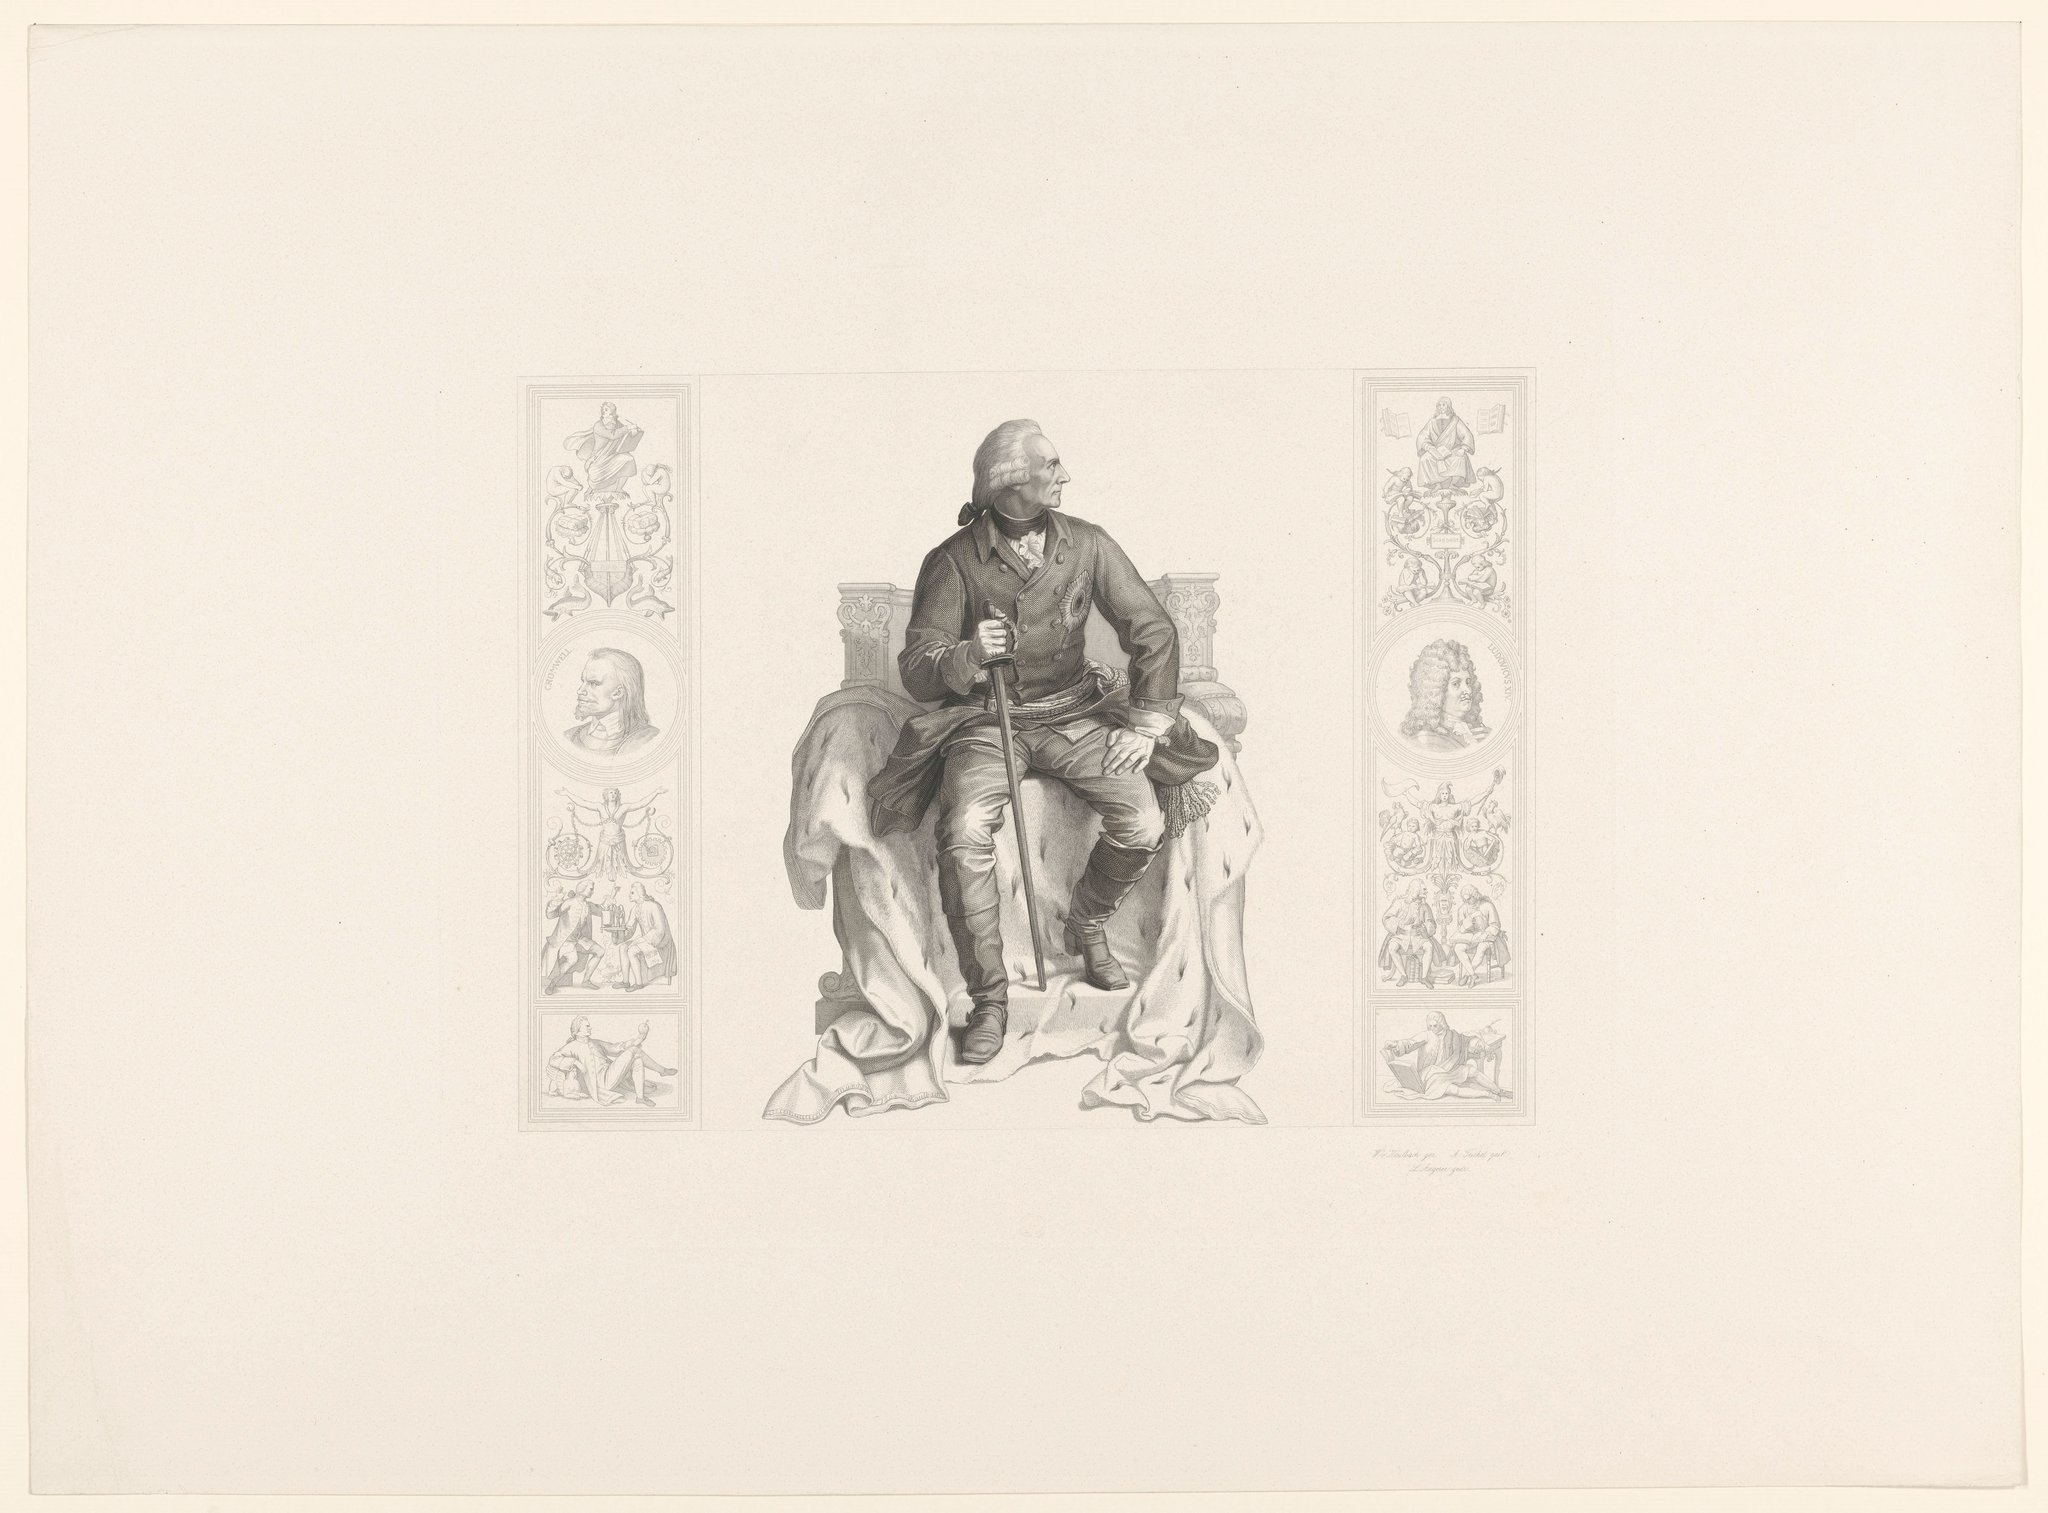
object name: print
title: Zittende vorst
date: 1832-1873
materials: paper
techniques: engraving, etching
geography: germany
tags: lodewijk xiv (koning van frankrijk), london, oliver cromwell, ruler, sovereign, historical persons not known by name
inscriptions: check stamp: ‘D A [...]’, collector's mark: Lugt 2165